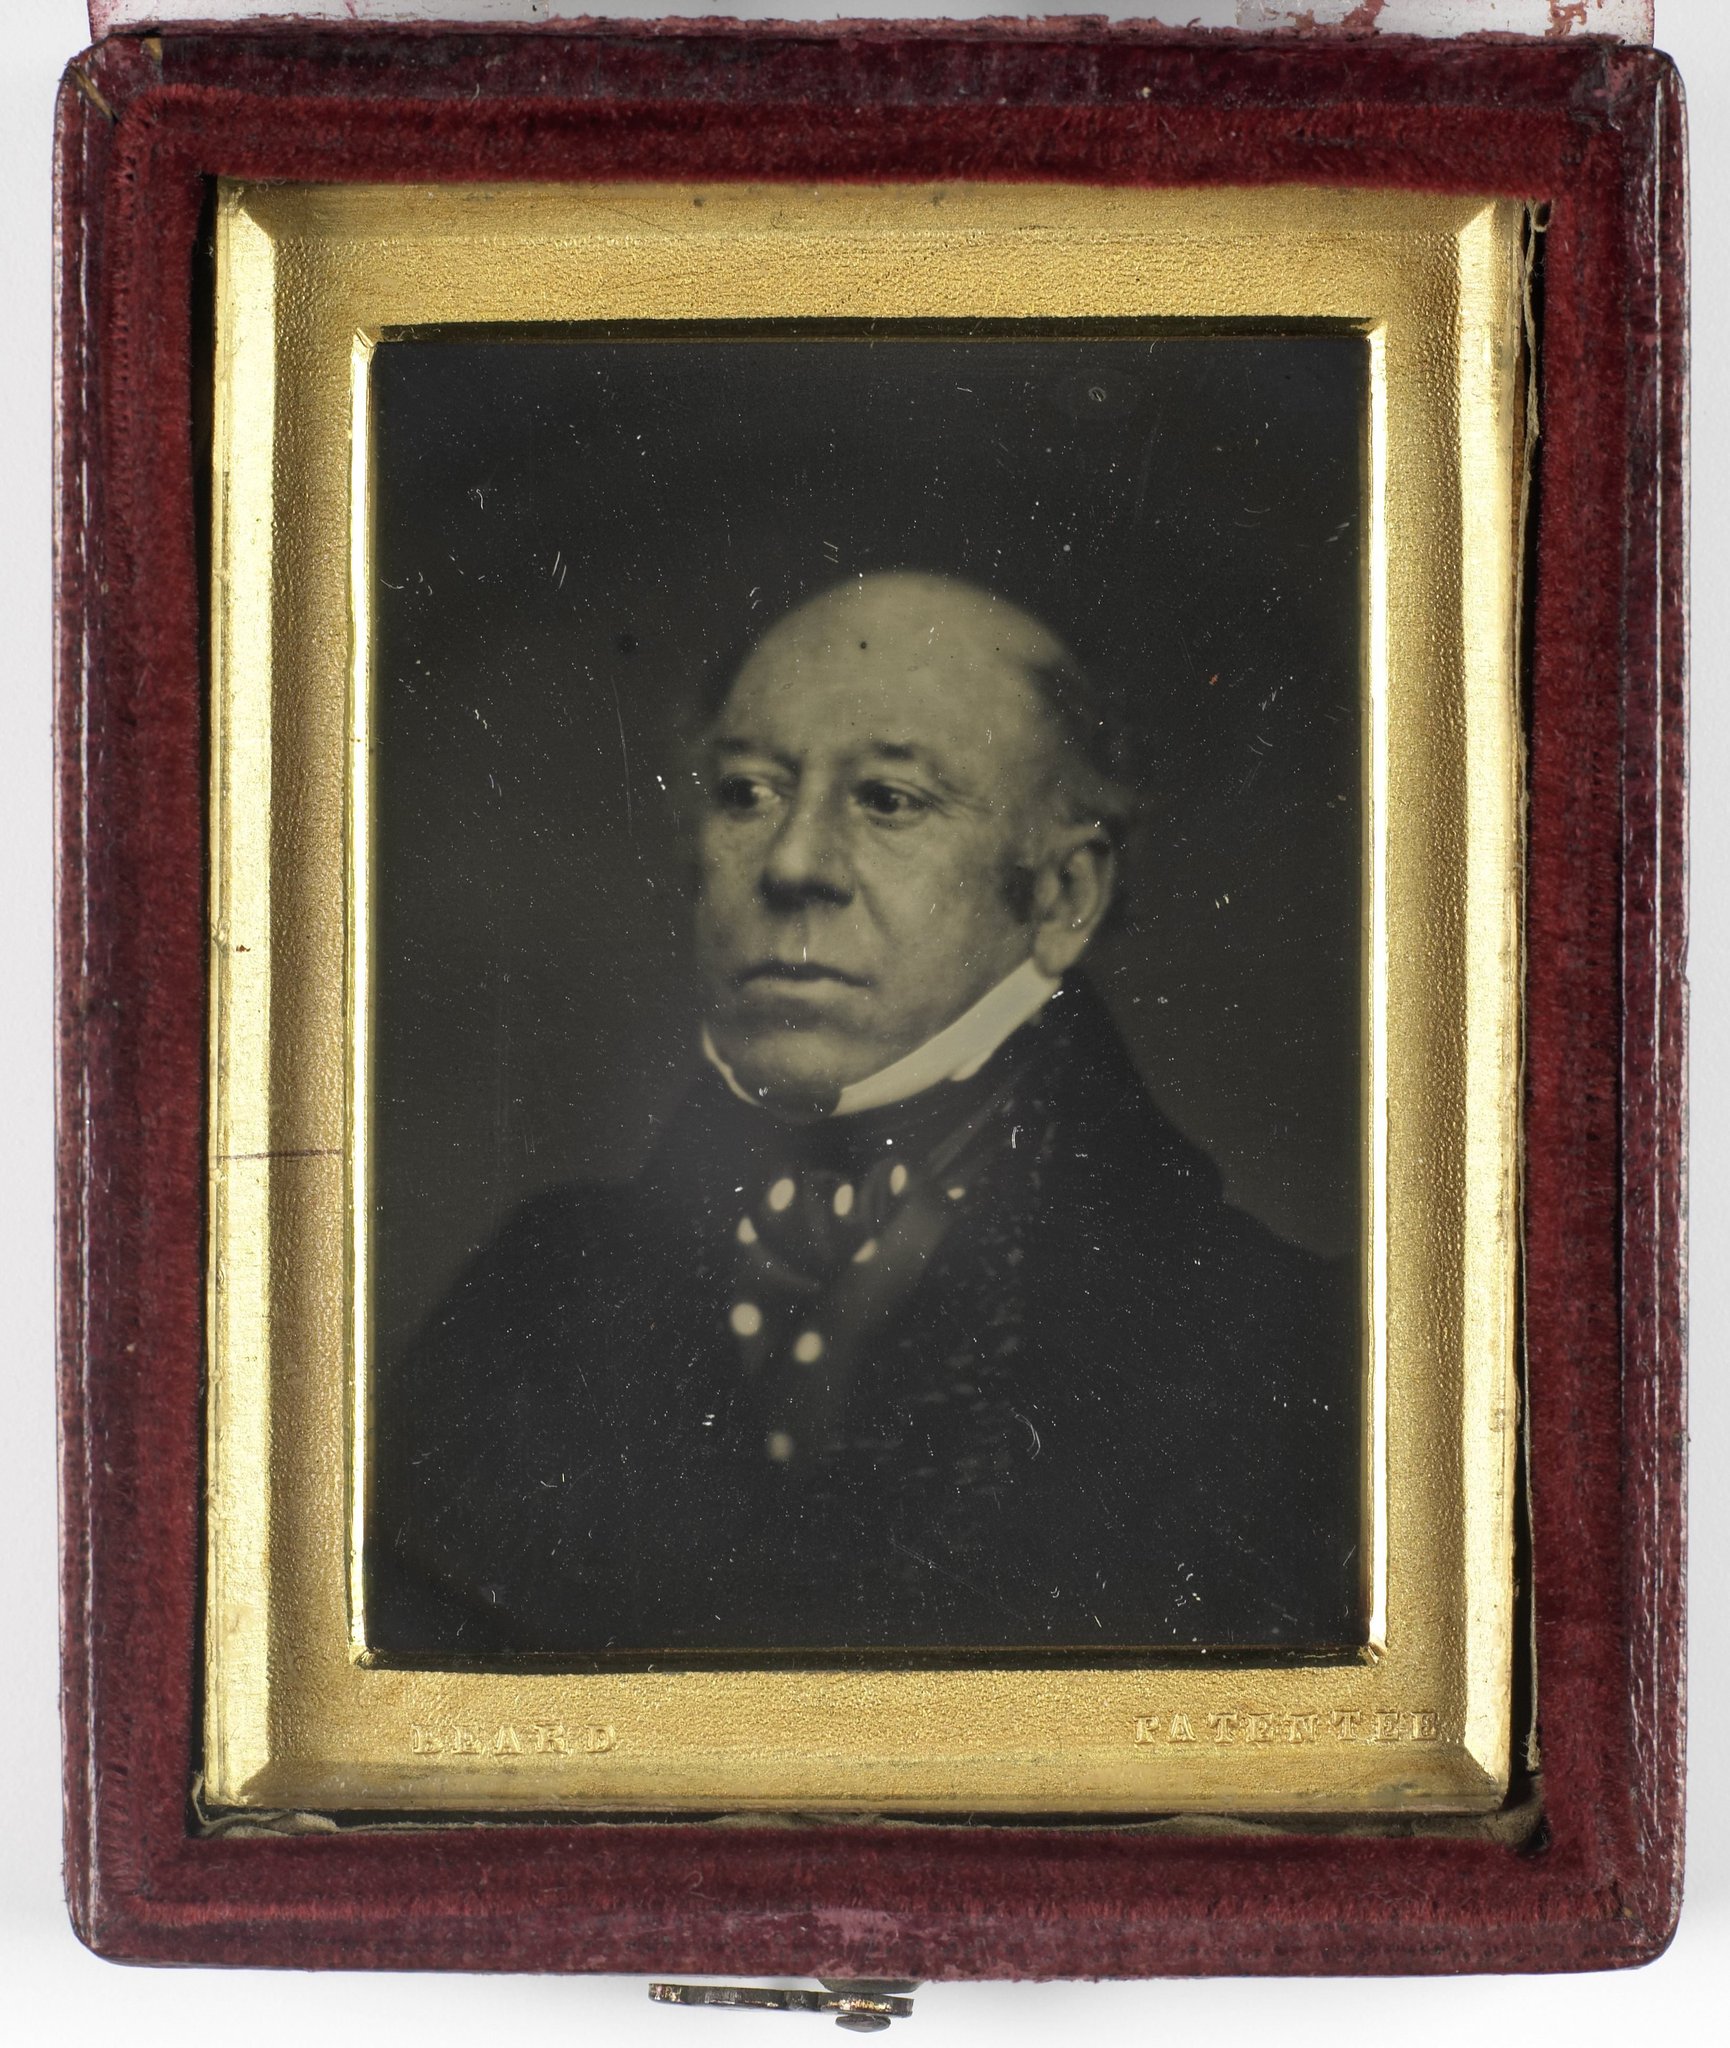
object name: photograph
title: Portret van een onbekende man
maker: richard beard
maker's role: fotograaf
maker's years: 1802-1888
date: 1840-1860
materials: copper, glass, leather, velvet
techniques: daguerreotype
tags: adult man, historical persons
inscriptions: inscription: ‘H E H B D’